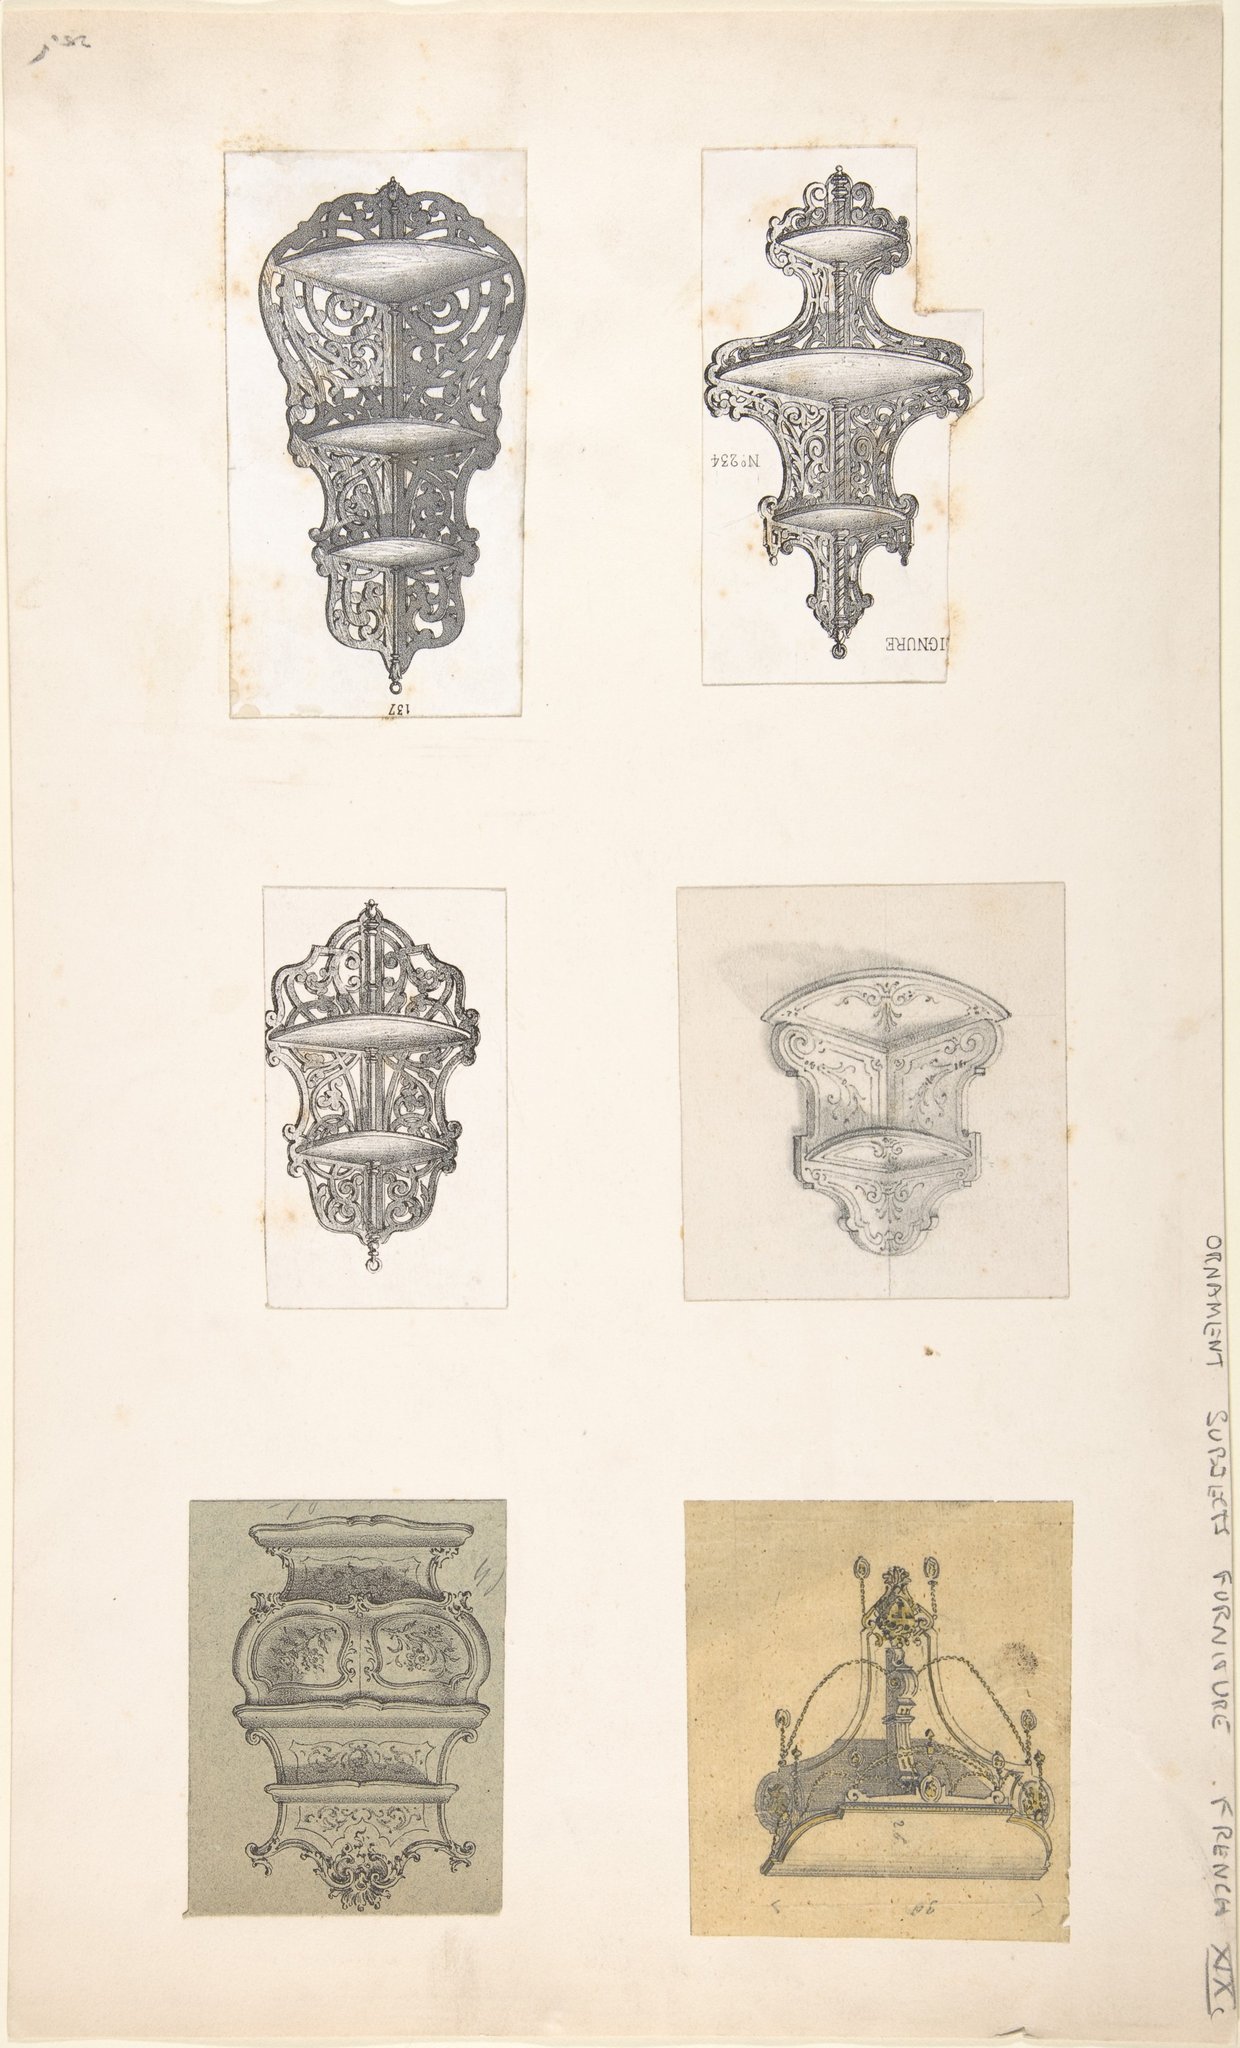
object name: drawing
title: Six Designs for Hanging Shelves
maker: anonymous, french, 19th century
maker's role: artist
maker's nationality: french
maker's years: 1800-1900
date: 1801-1900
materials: graphite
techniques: lithograph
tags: furniture